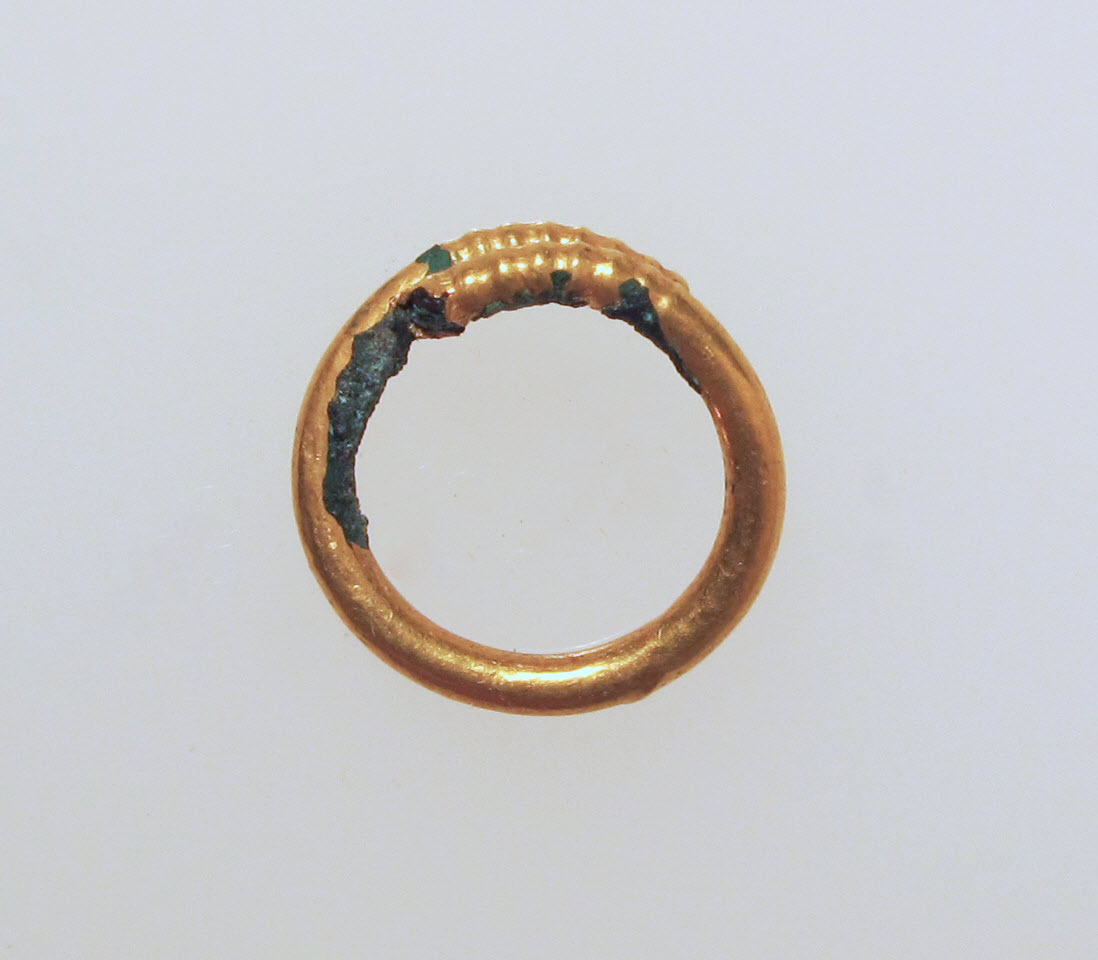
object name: earring or spiral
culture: cypriot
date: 3900 BCE-100 CE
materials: bronze, gold